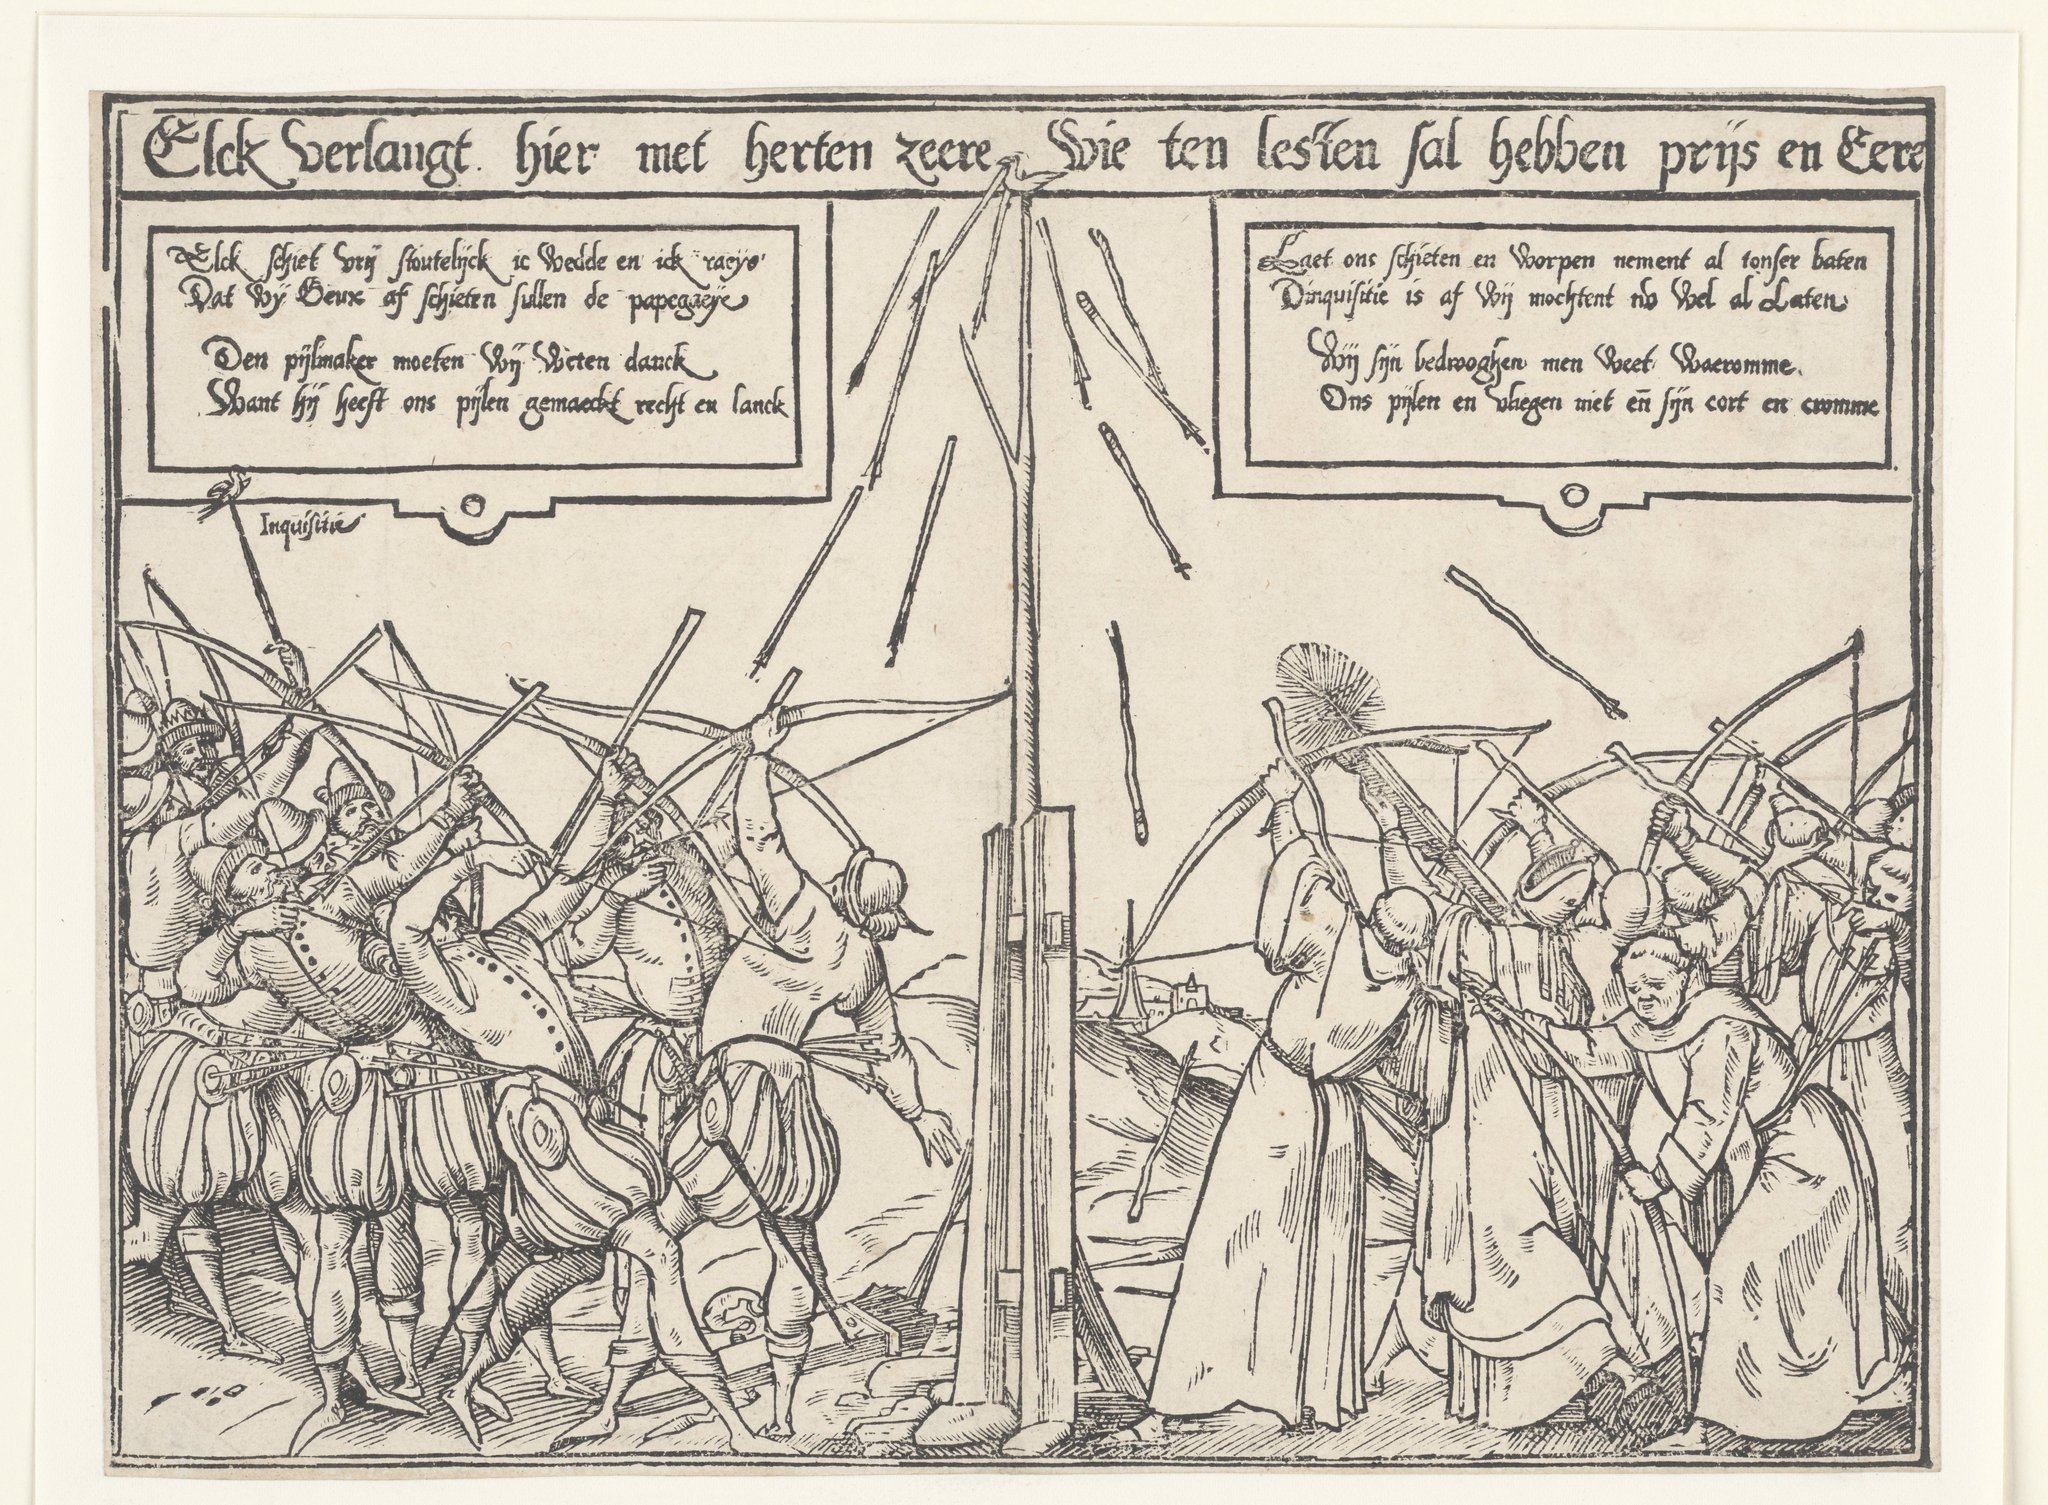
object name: print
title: Parrot Shooting, Contest between Beggars and Monks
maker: Anonymous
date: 1566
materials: paper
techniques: woodcut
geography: low countries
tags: reformation (roman catholic church vs. protestantism), shooting-the-bird (on a high pole)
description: Papegaaischieten. Wedstrijd prijsschieten of vogelschieten met pijl en boog om de papegaai. Links een groep van geuzen dat met rechte pijlen schiet, de katholieken rechts schieten met kromme pijlen waardoor zij hun doel niet raken. De geuzen hebben de vogel van de inquisitie al afgeschoten en houden deze als een trofee omhoog. In het midden een lange paal met bovenop de papegaai of vogel. Allegorie op de strijd rond de invoering van de Spaanse Inquisitie, ca. 1566. Boven 2 cartouches met elk 4 regels in het Nederlands.